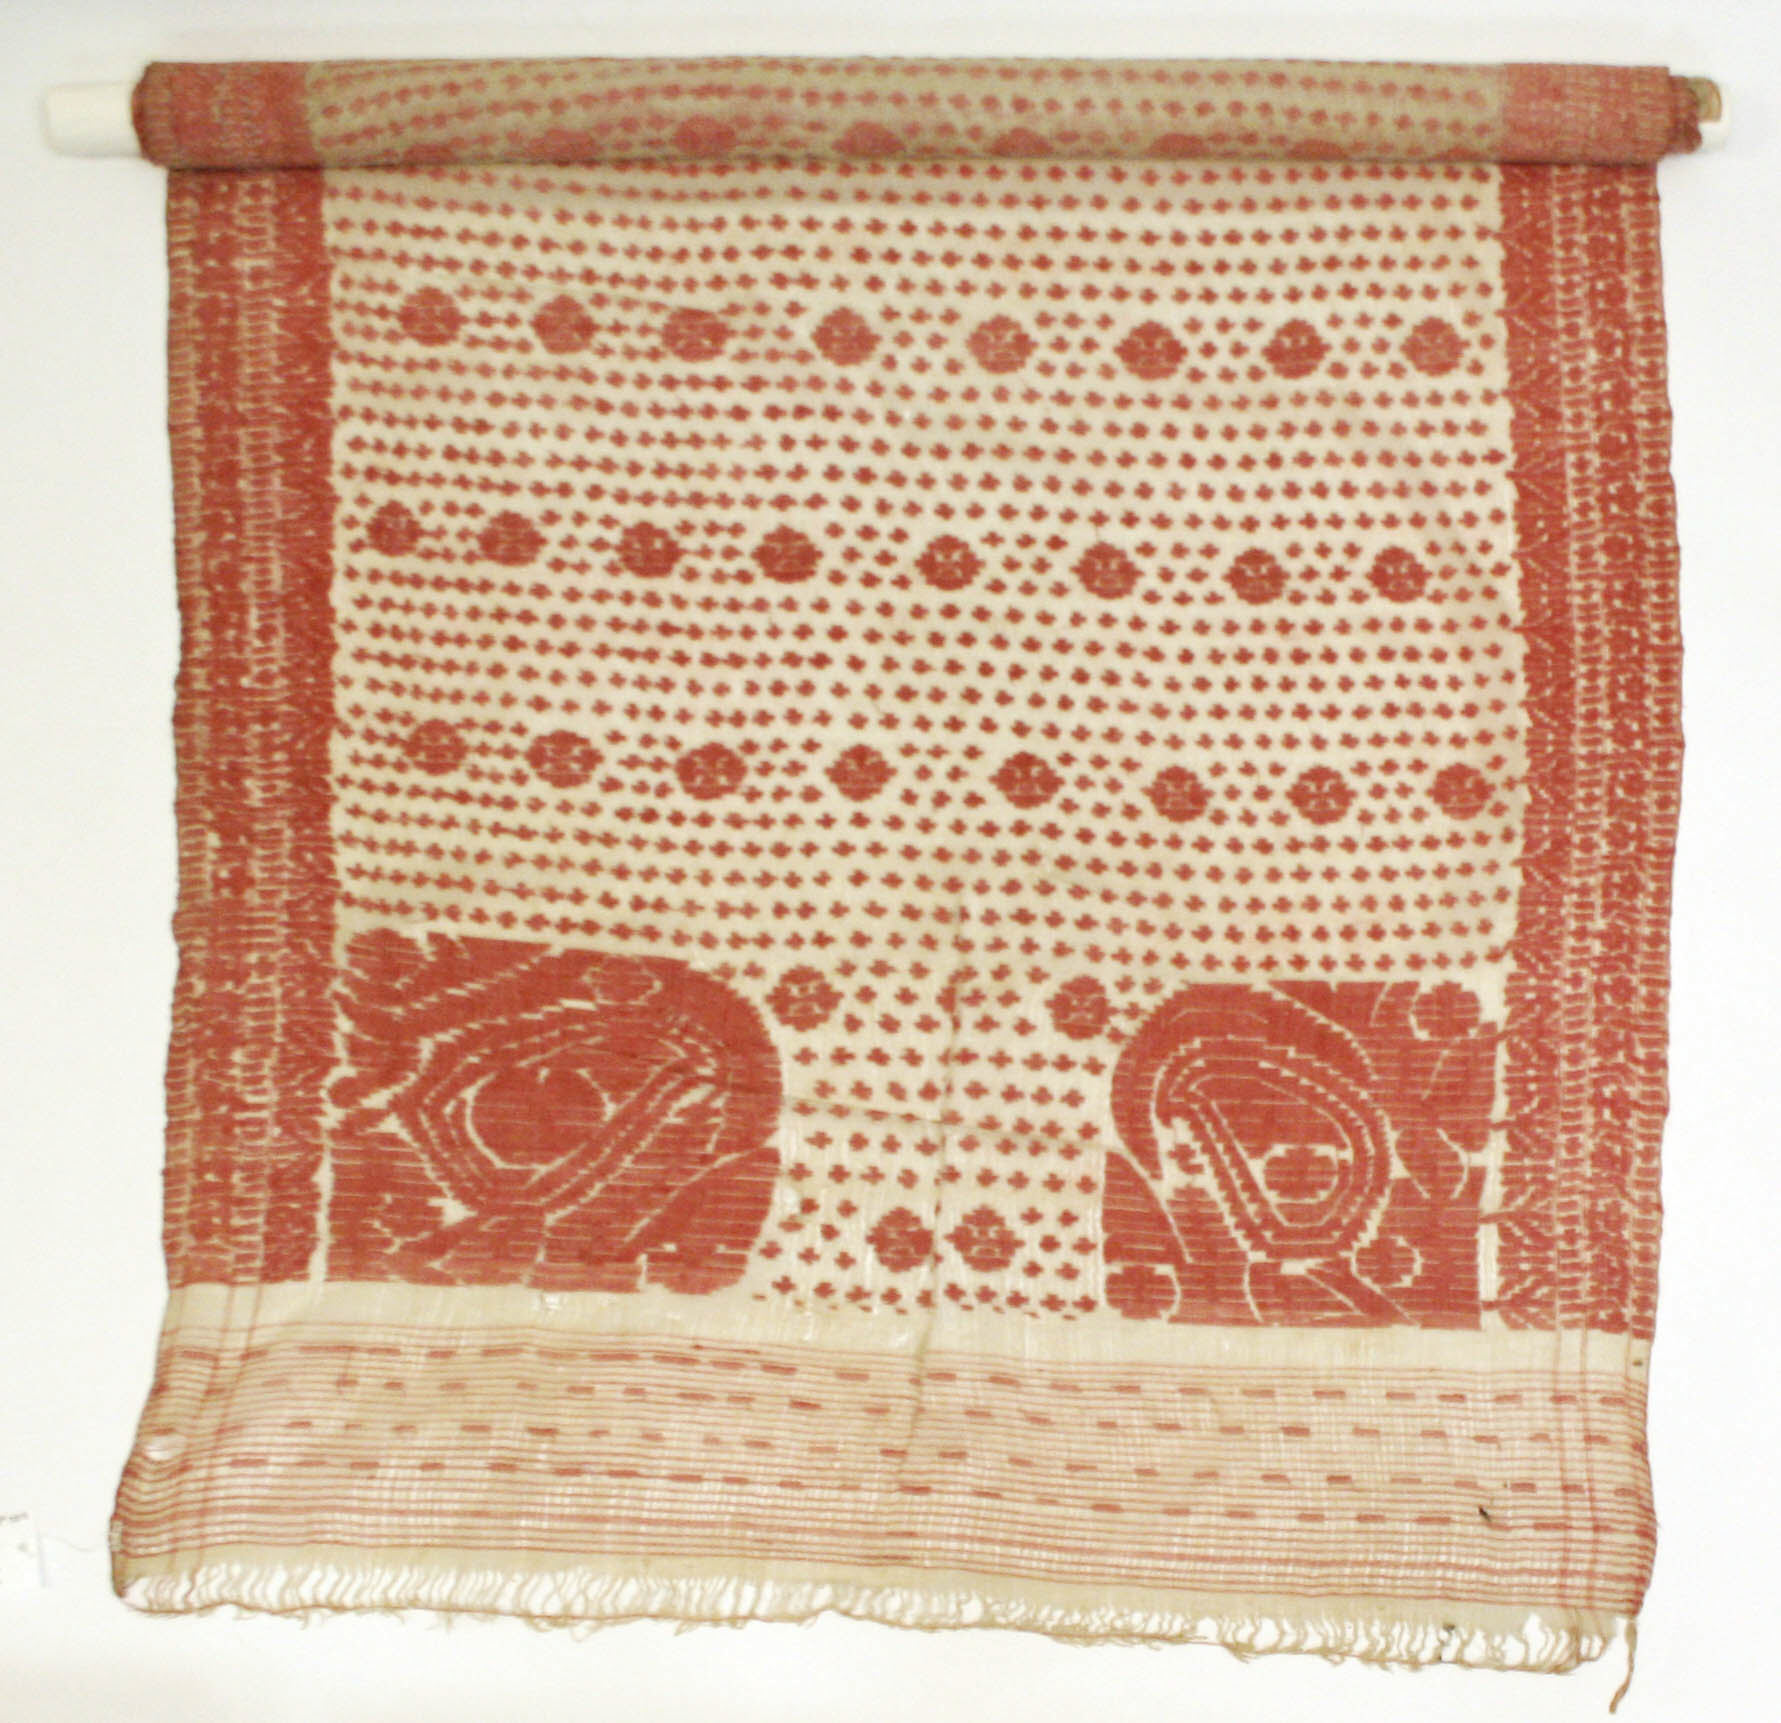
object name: chudar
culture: indian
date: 1801-1900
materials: cotton